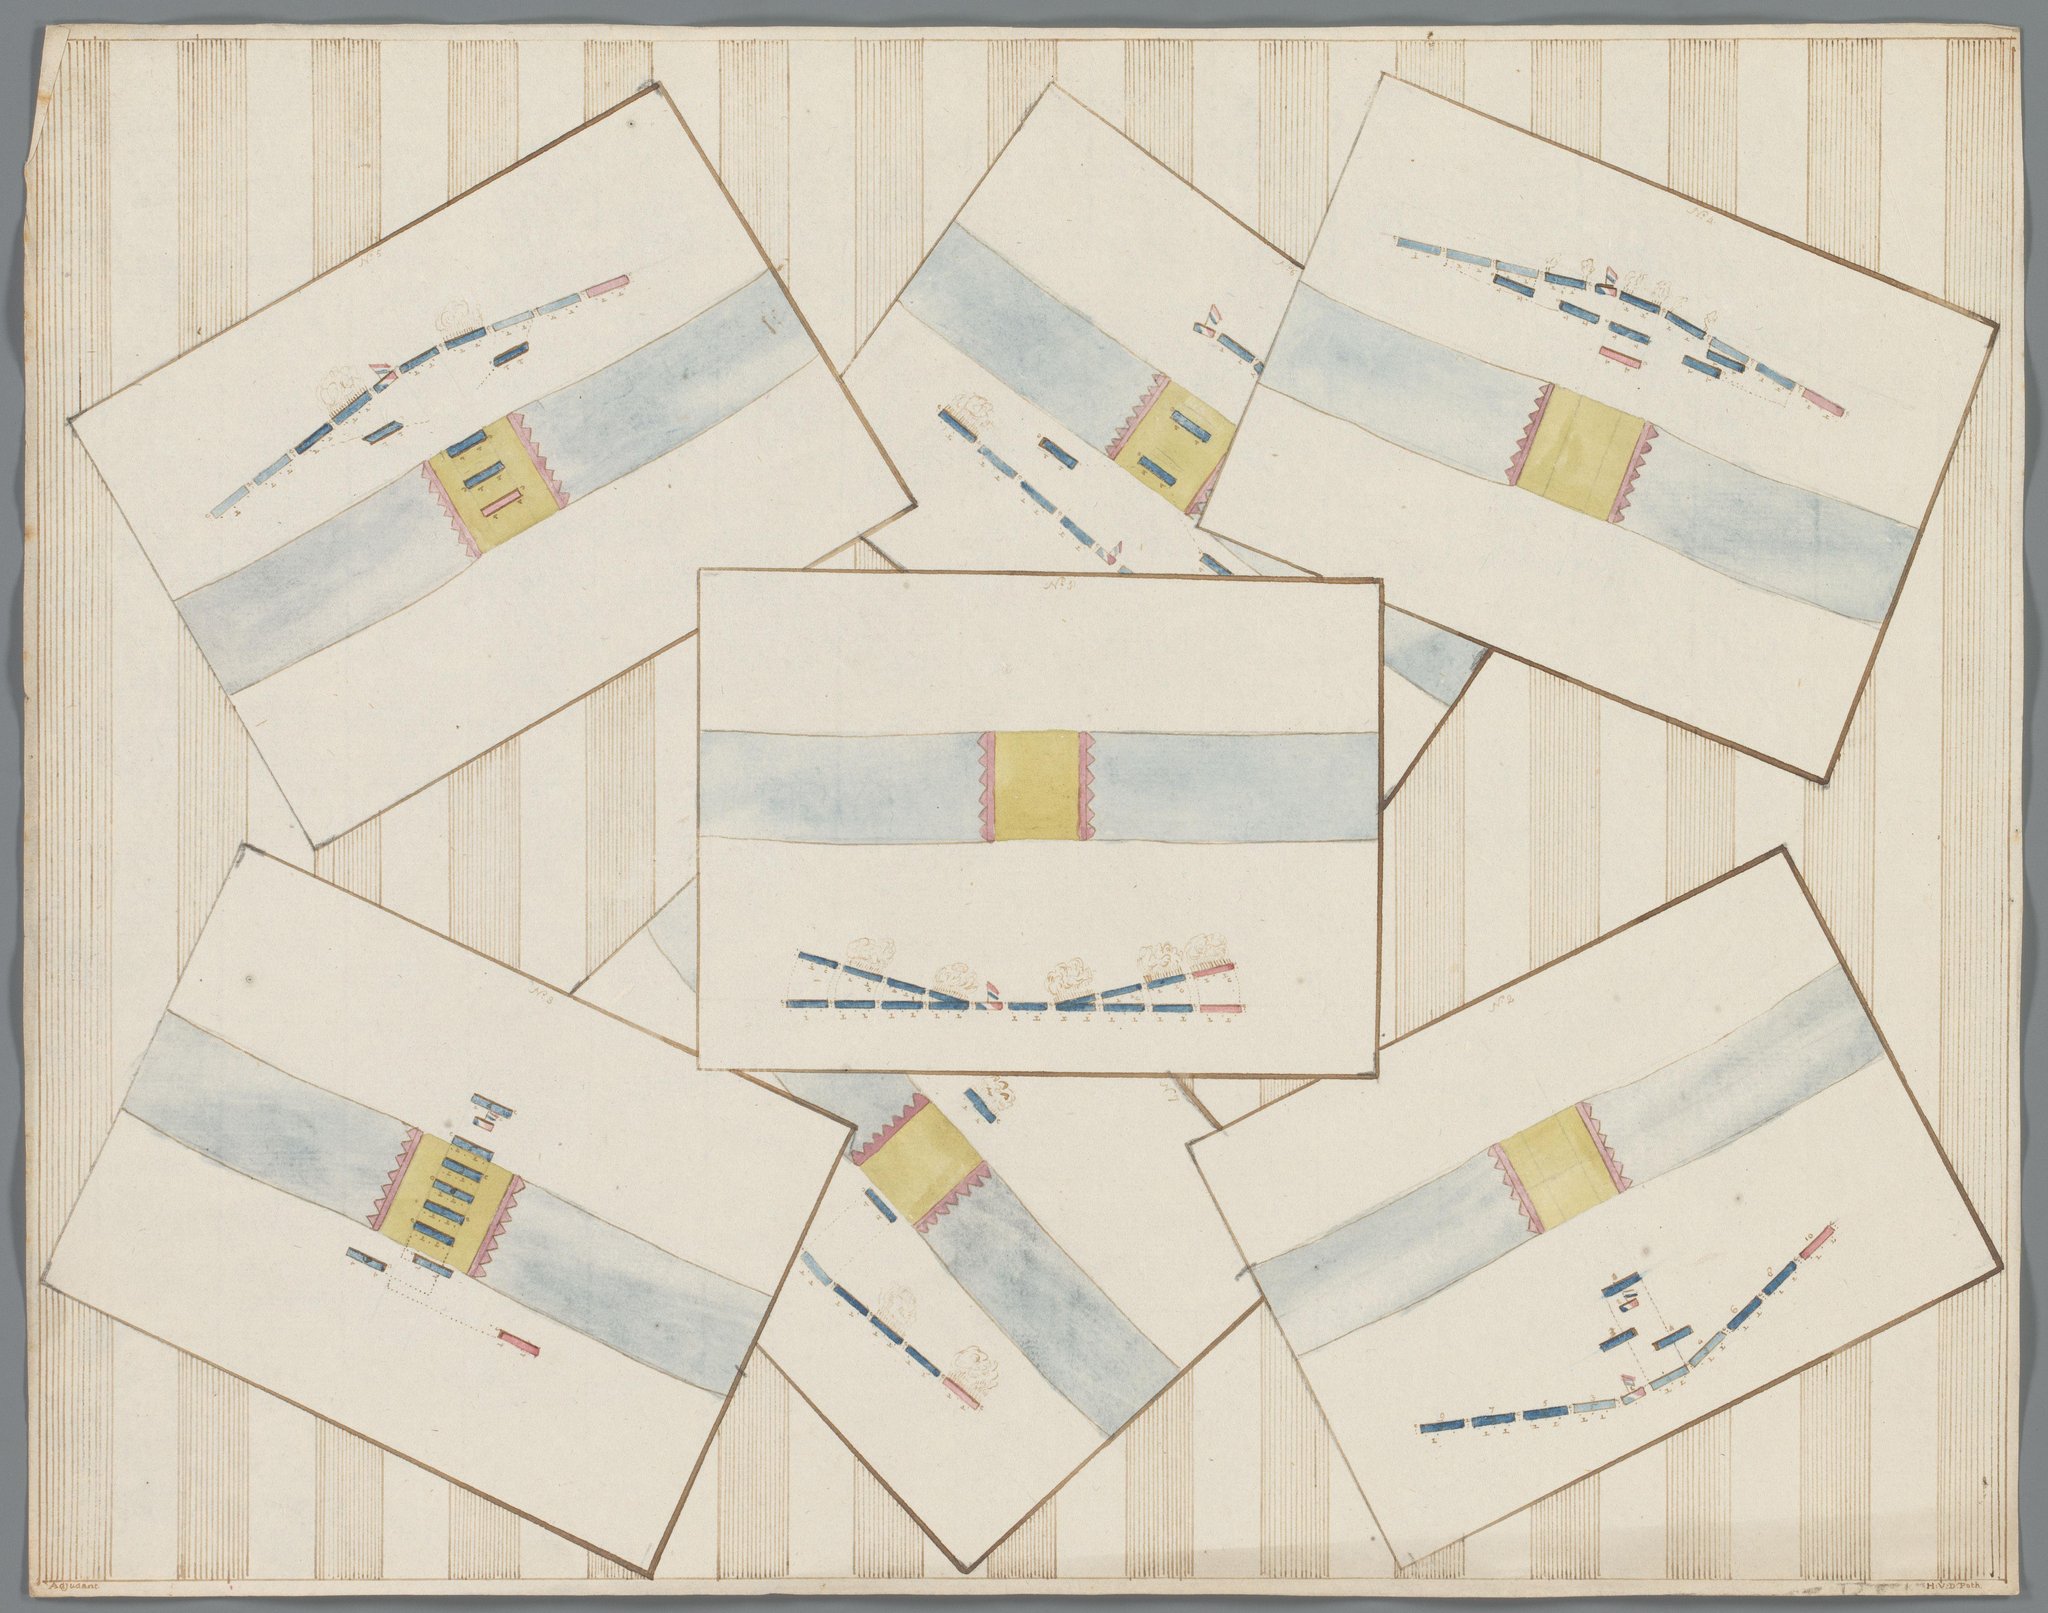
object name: drawing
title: Manoeuvres van de compagnieën, ca. 1799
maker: hendrik van der poth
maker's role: draughtsman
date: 1799-1803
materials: paper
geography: netherlands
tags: manoeuvre ~ military training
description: Blad met zeven kaartjes van verschillende manoeuvres van de zeven compagnieën van het Bataafse bataljon. Ten tijde van de Brits-Russische expeditie in 1799. Onderdeel van een groep van zeventien getekende kaarten.